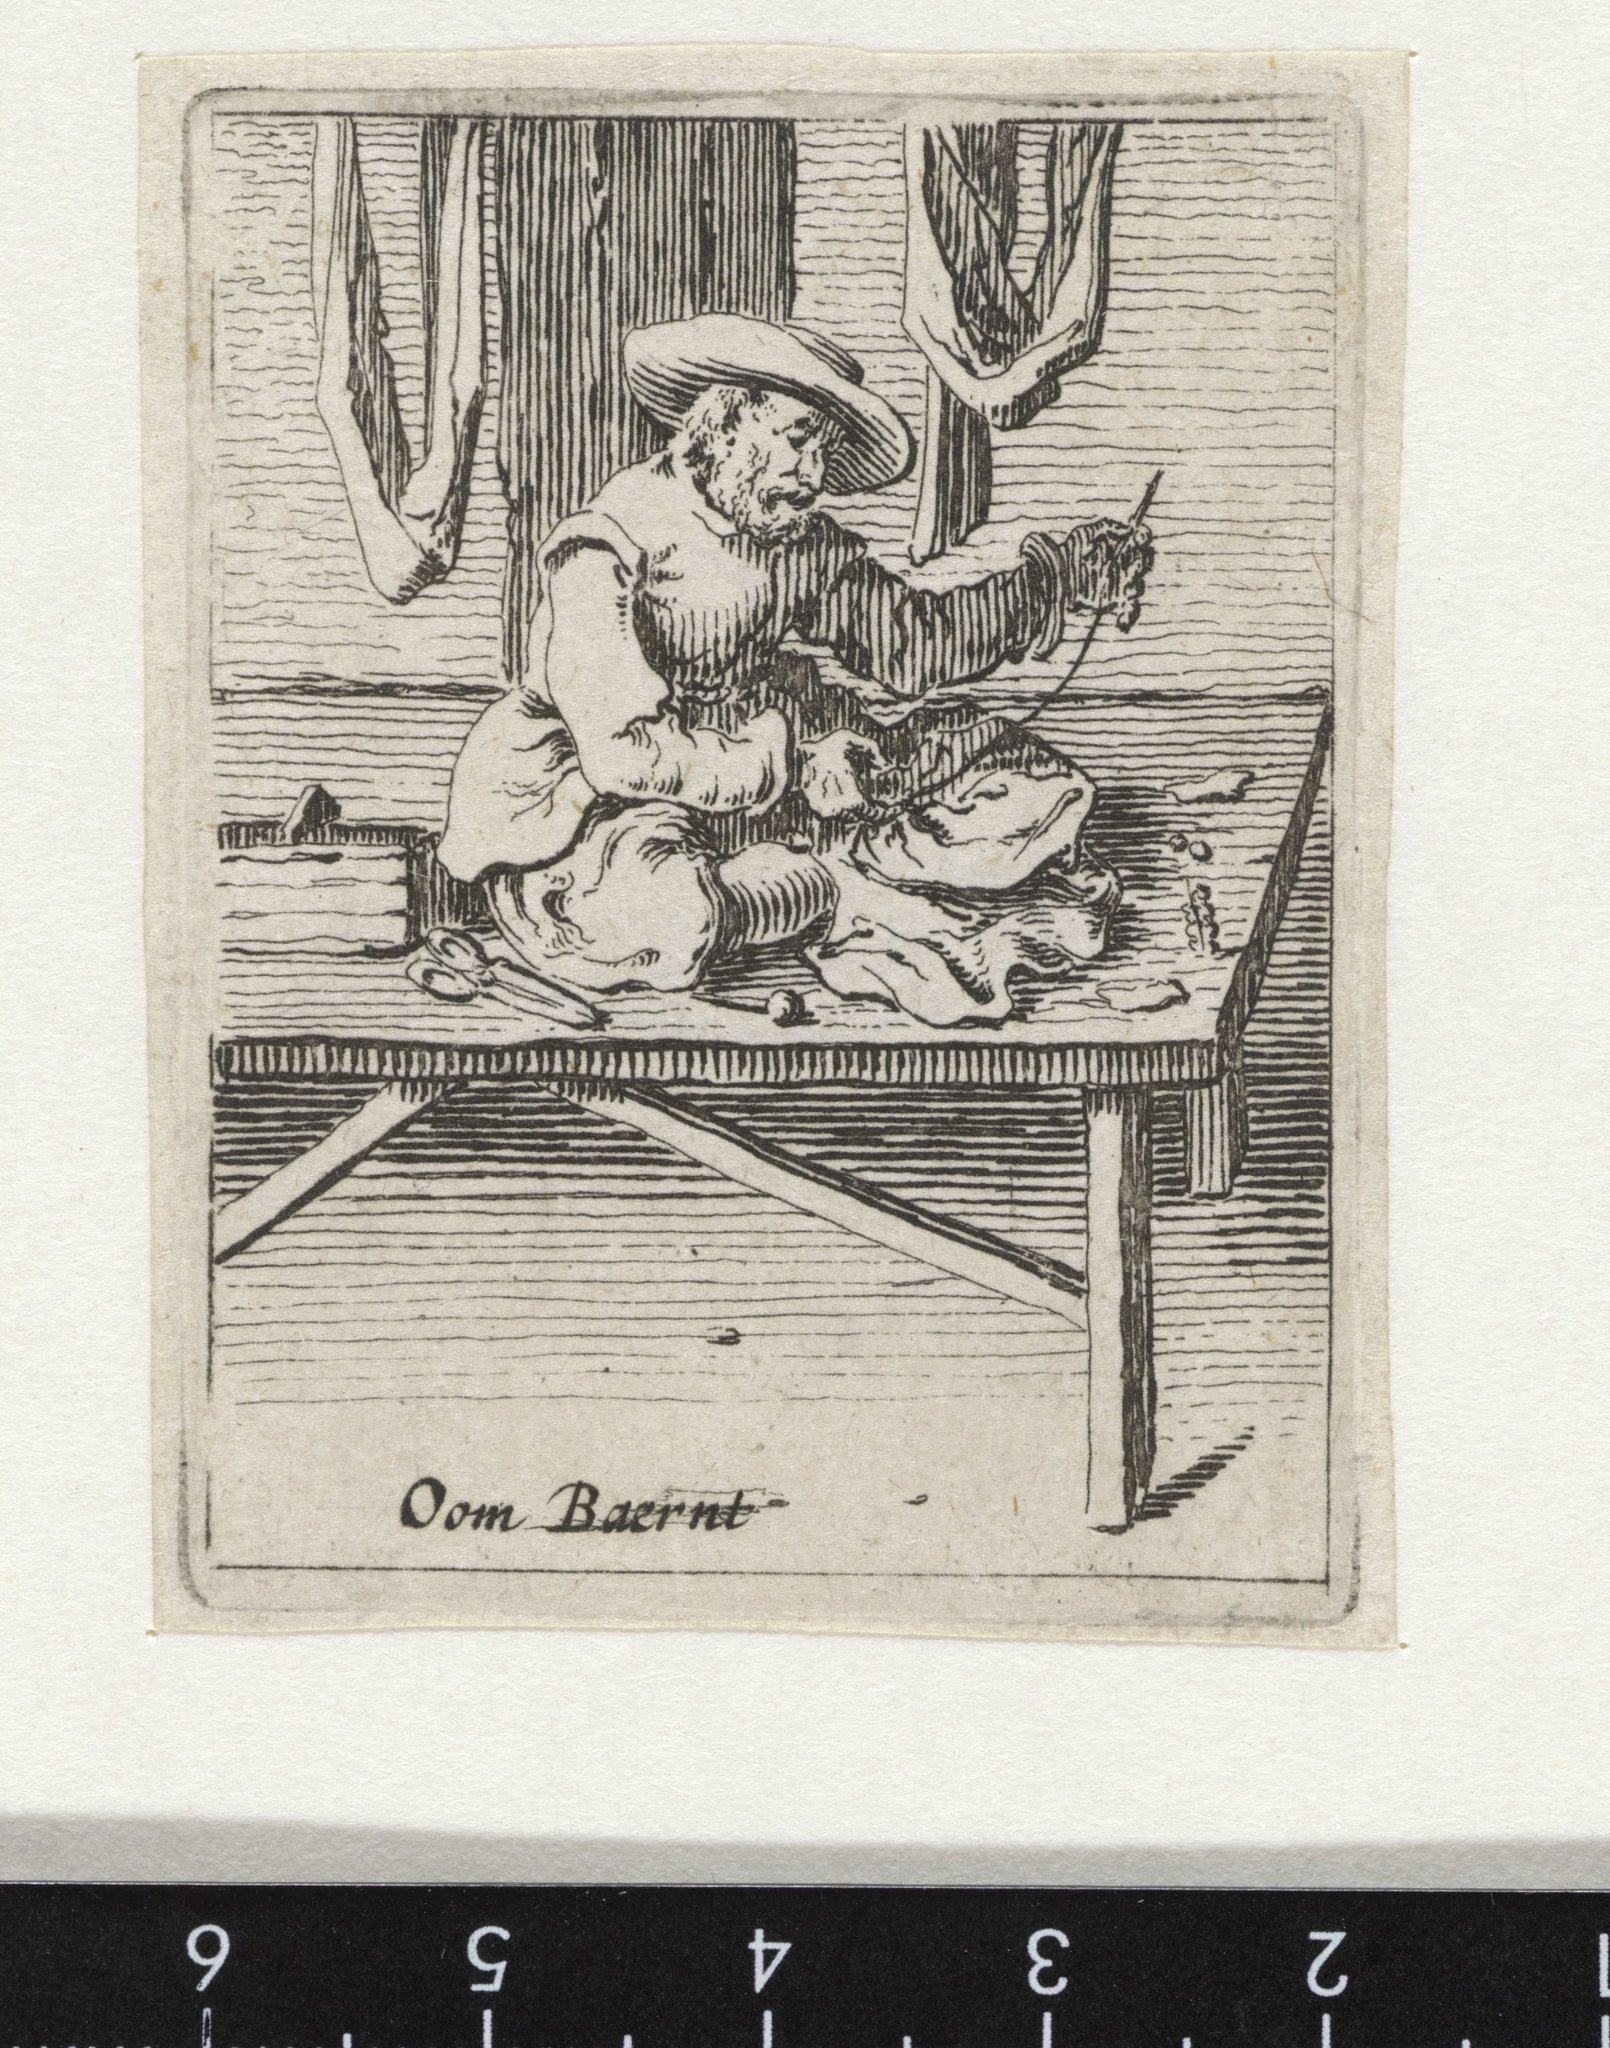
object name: print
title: Kleermaker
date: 1638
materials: paper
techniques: etching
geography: amsterdam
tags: tailor, dressmaker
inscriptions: collector's mark: Lugt 2228, collector's mark: Lugt 2760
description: Een kleermaker (Oom Baernt) zit op een tafel kleding te naaien. Achter hem hangen lappen stof. De prent maakt deel uit van een serie van 32 prenten met genretaferelen.